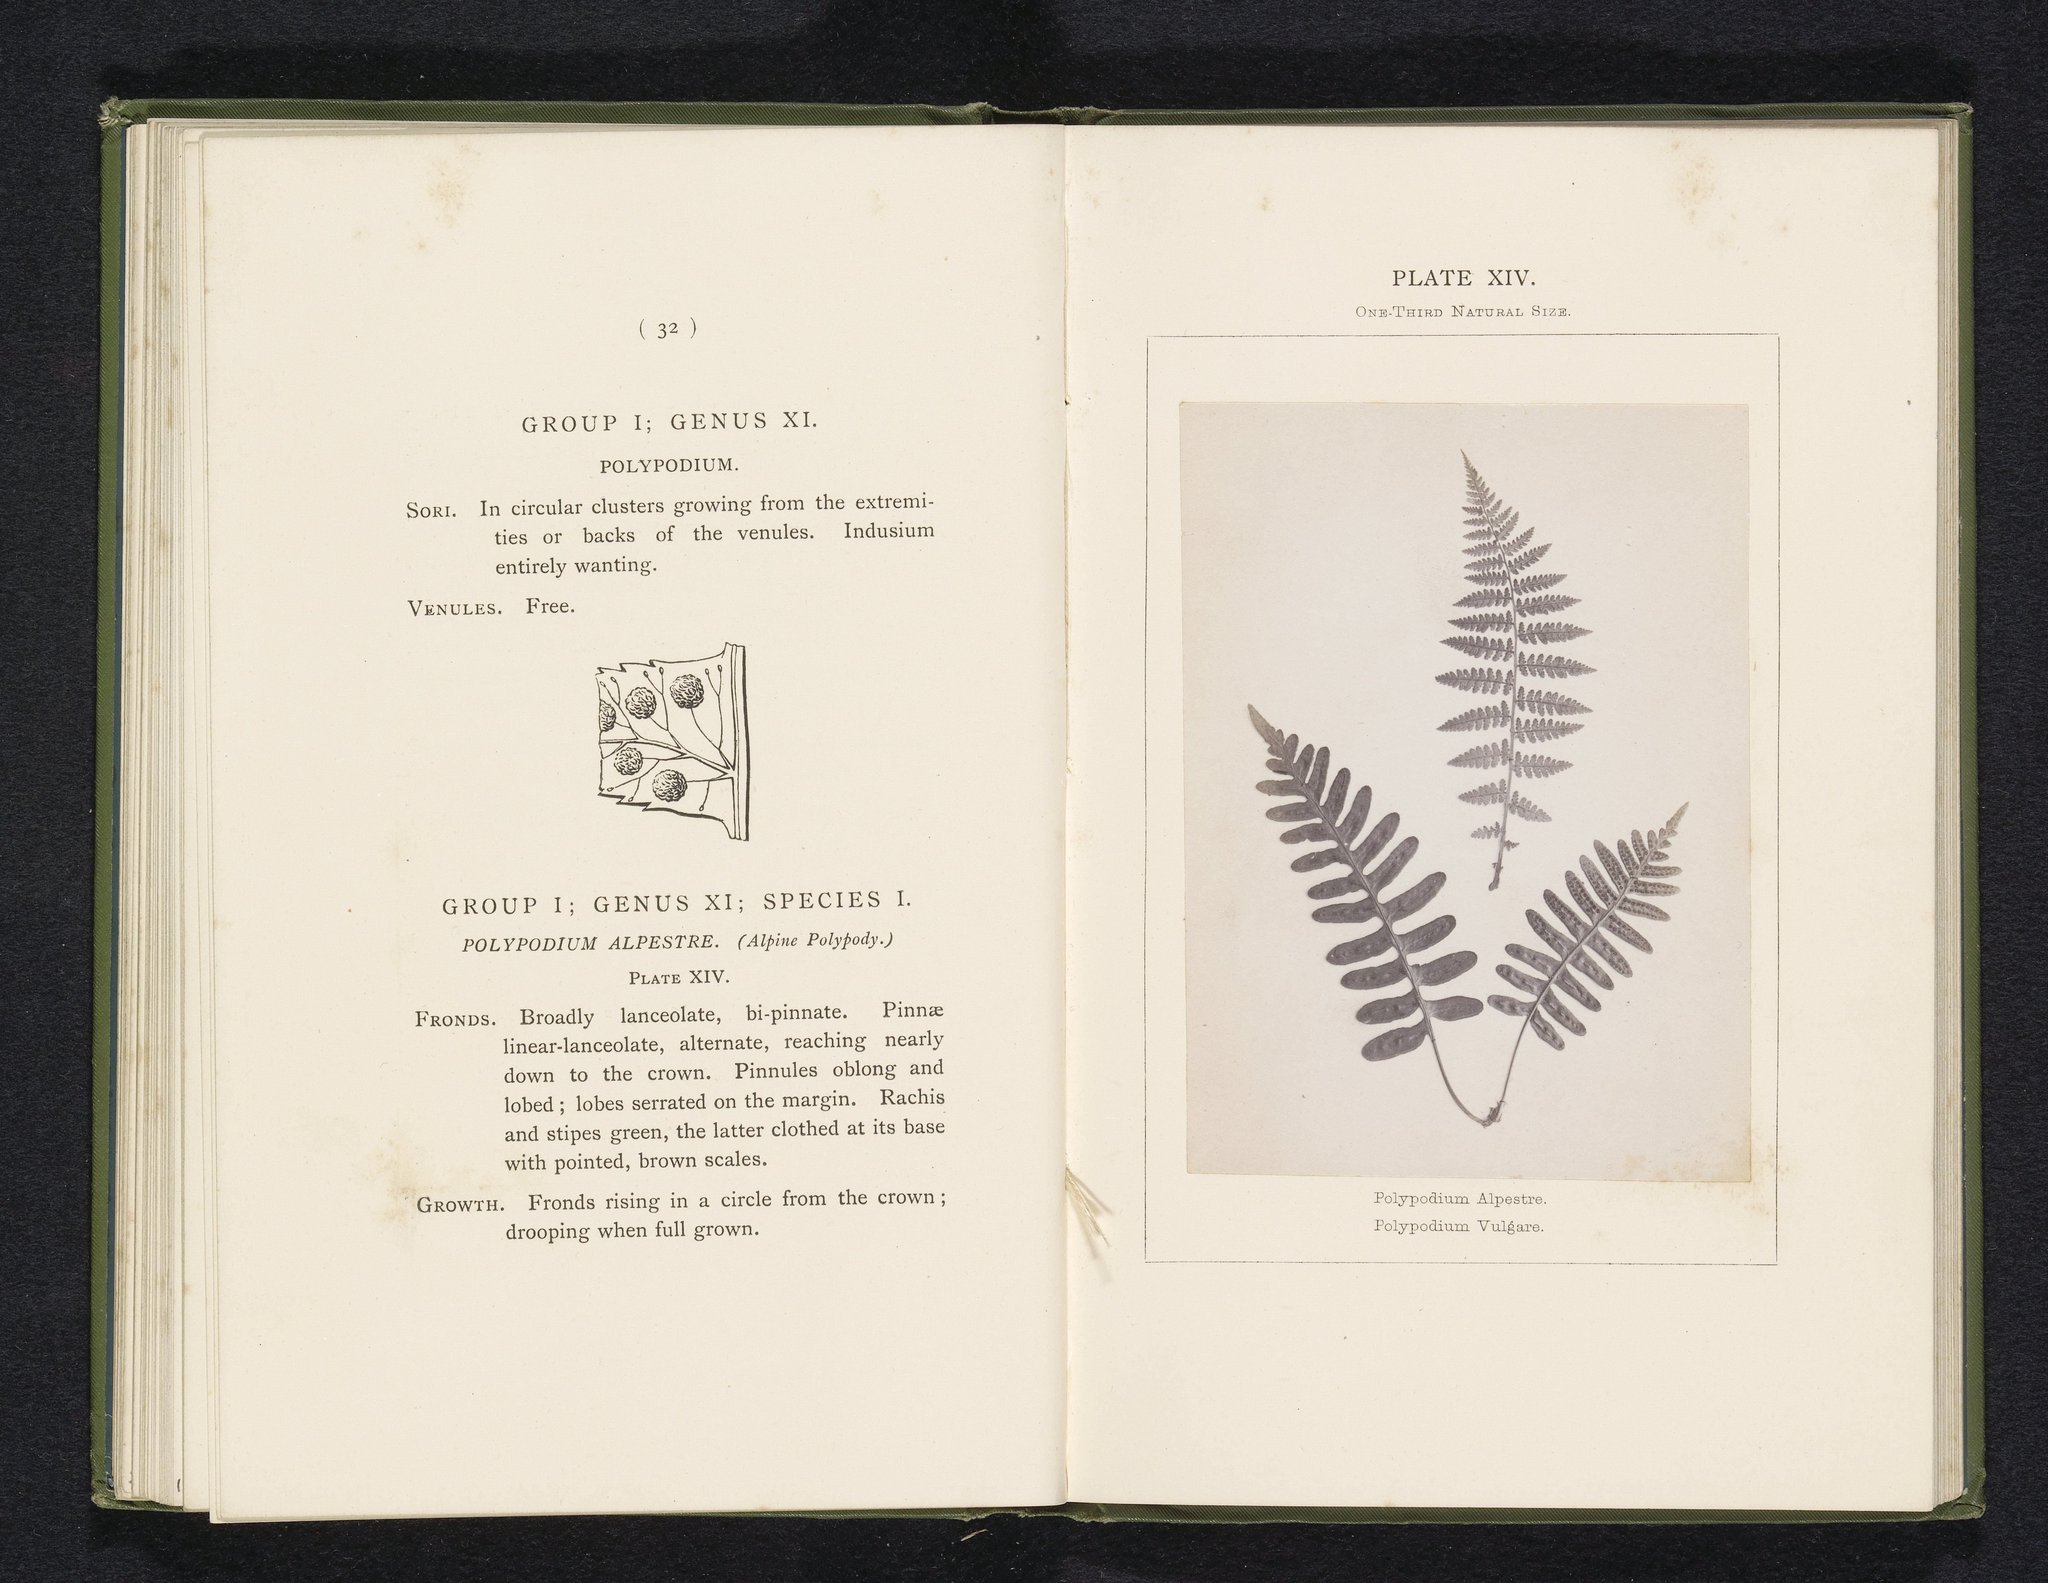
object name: photograph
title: Polypodium Alpestre. Polypodium Vulgare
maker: sydney courtauld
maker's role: botanicus, fotograaf, schrijver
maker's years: 1840-1899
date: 1867-1877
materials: photographic support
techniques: albumen print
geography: england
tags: ferns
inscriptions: inscription: ‘Plate XIV. One-third natural size.’